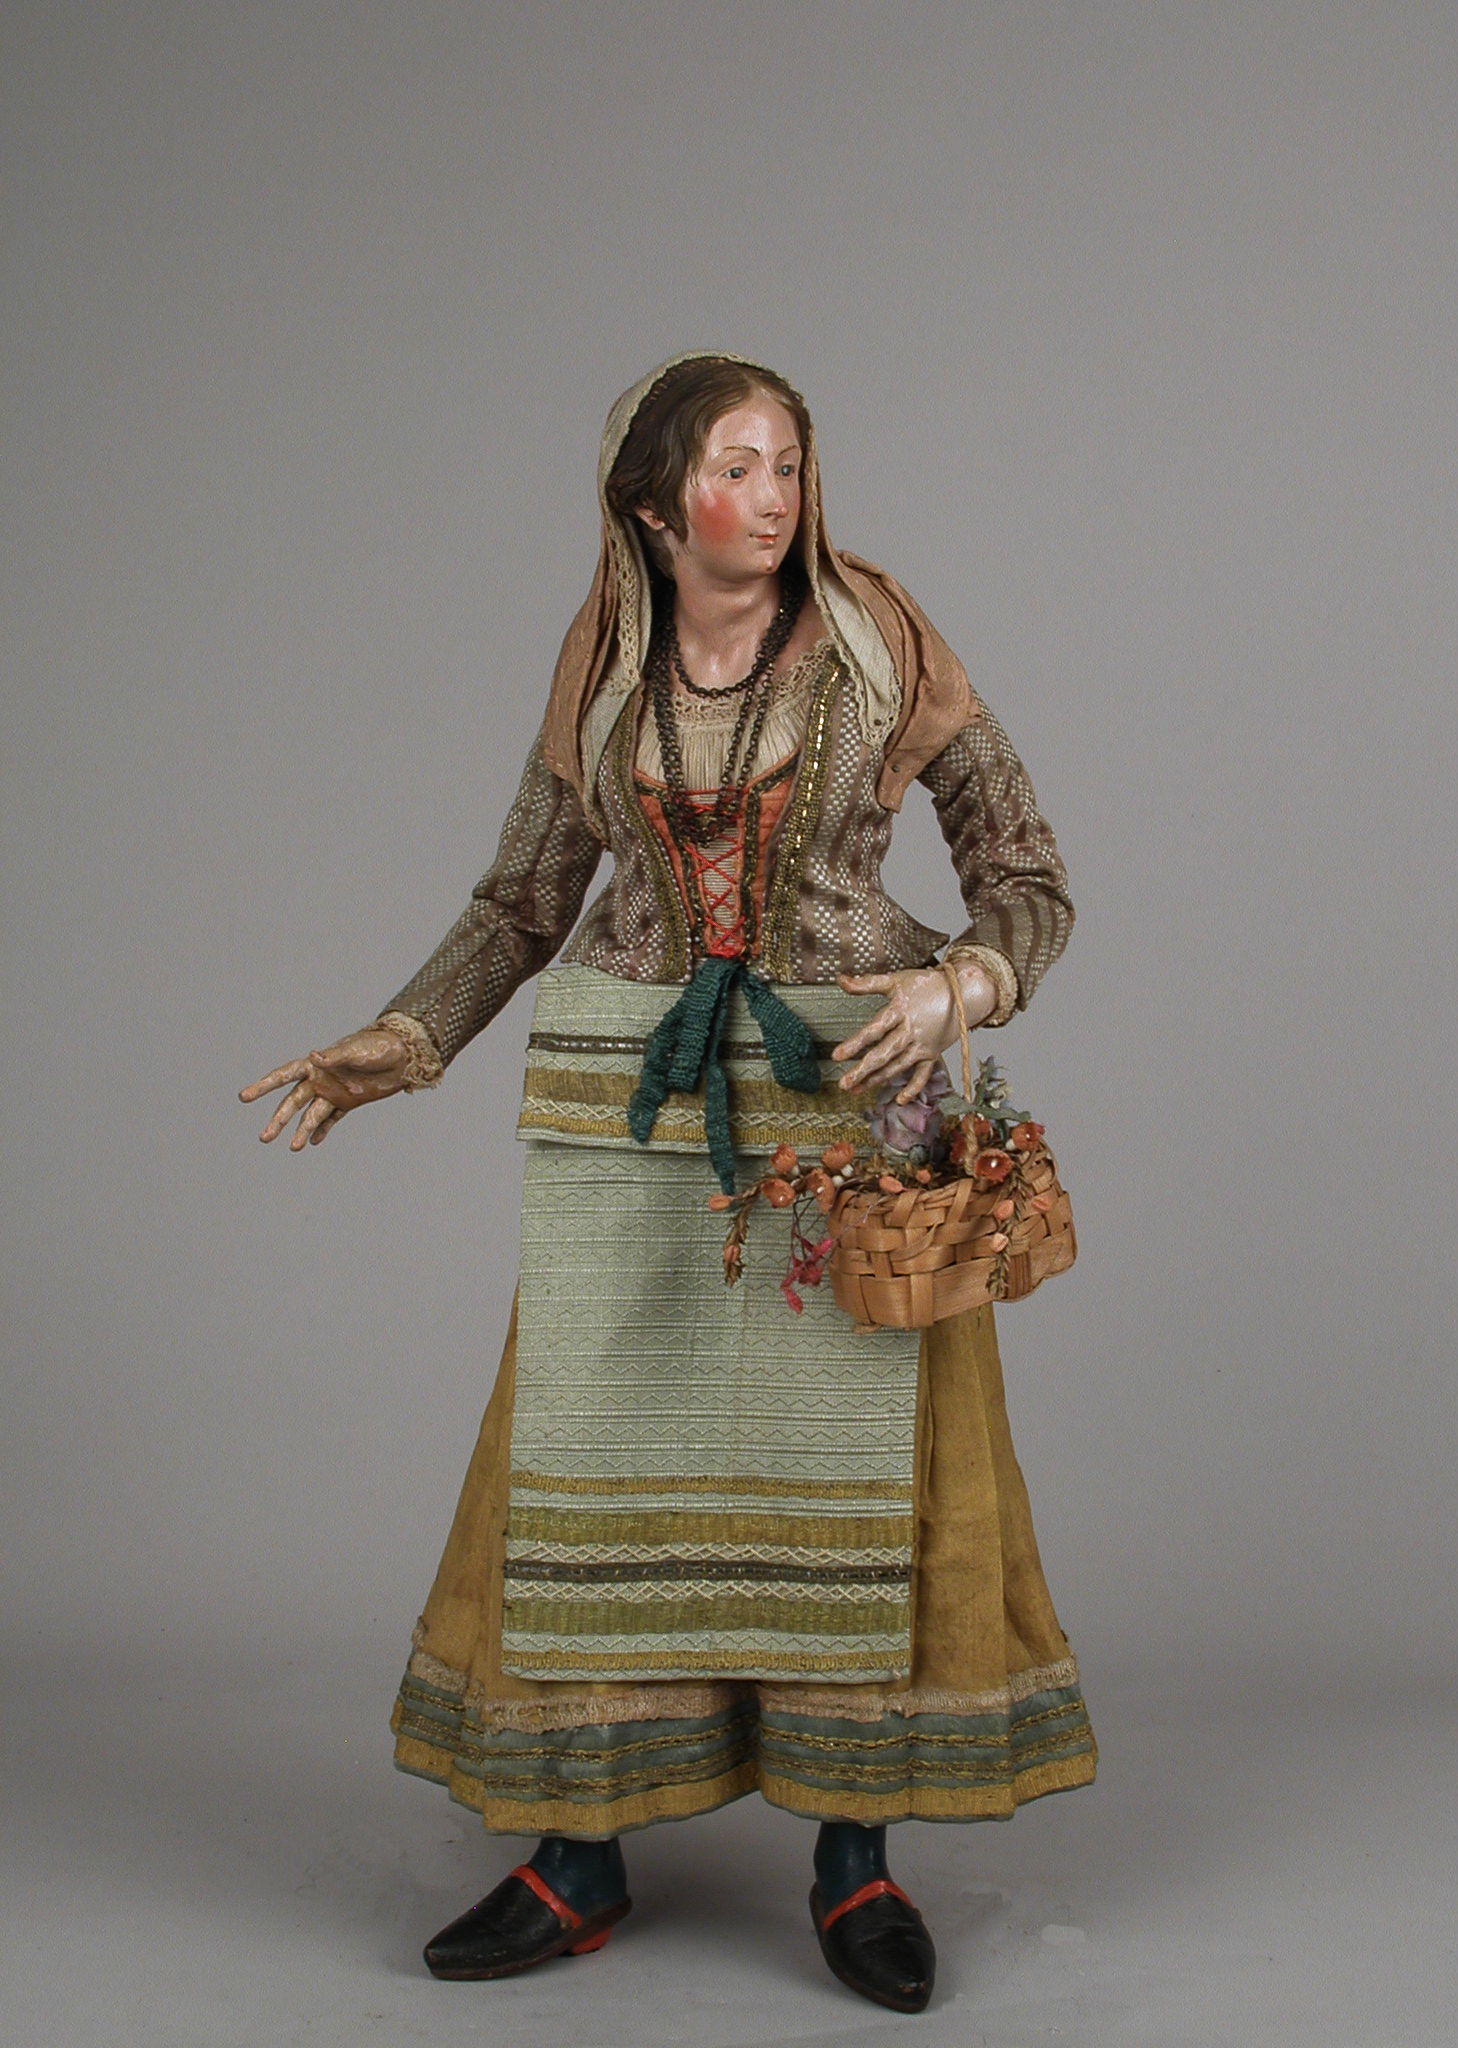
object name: crèche figure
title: Young woman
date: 1701-1800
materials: terracotta, wood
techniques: polychrome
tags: women